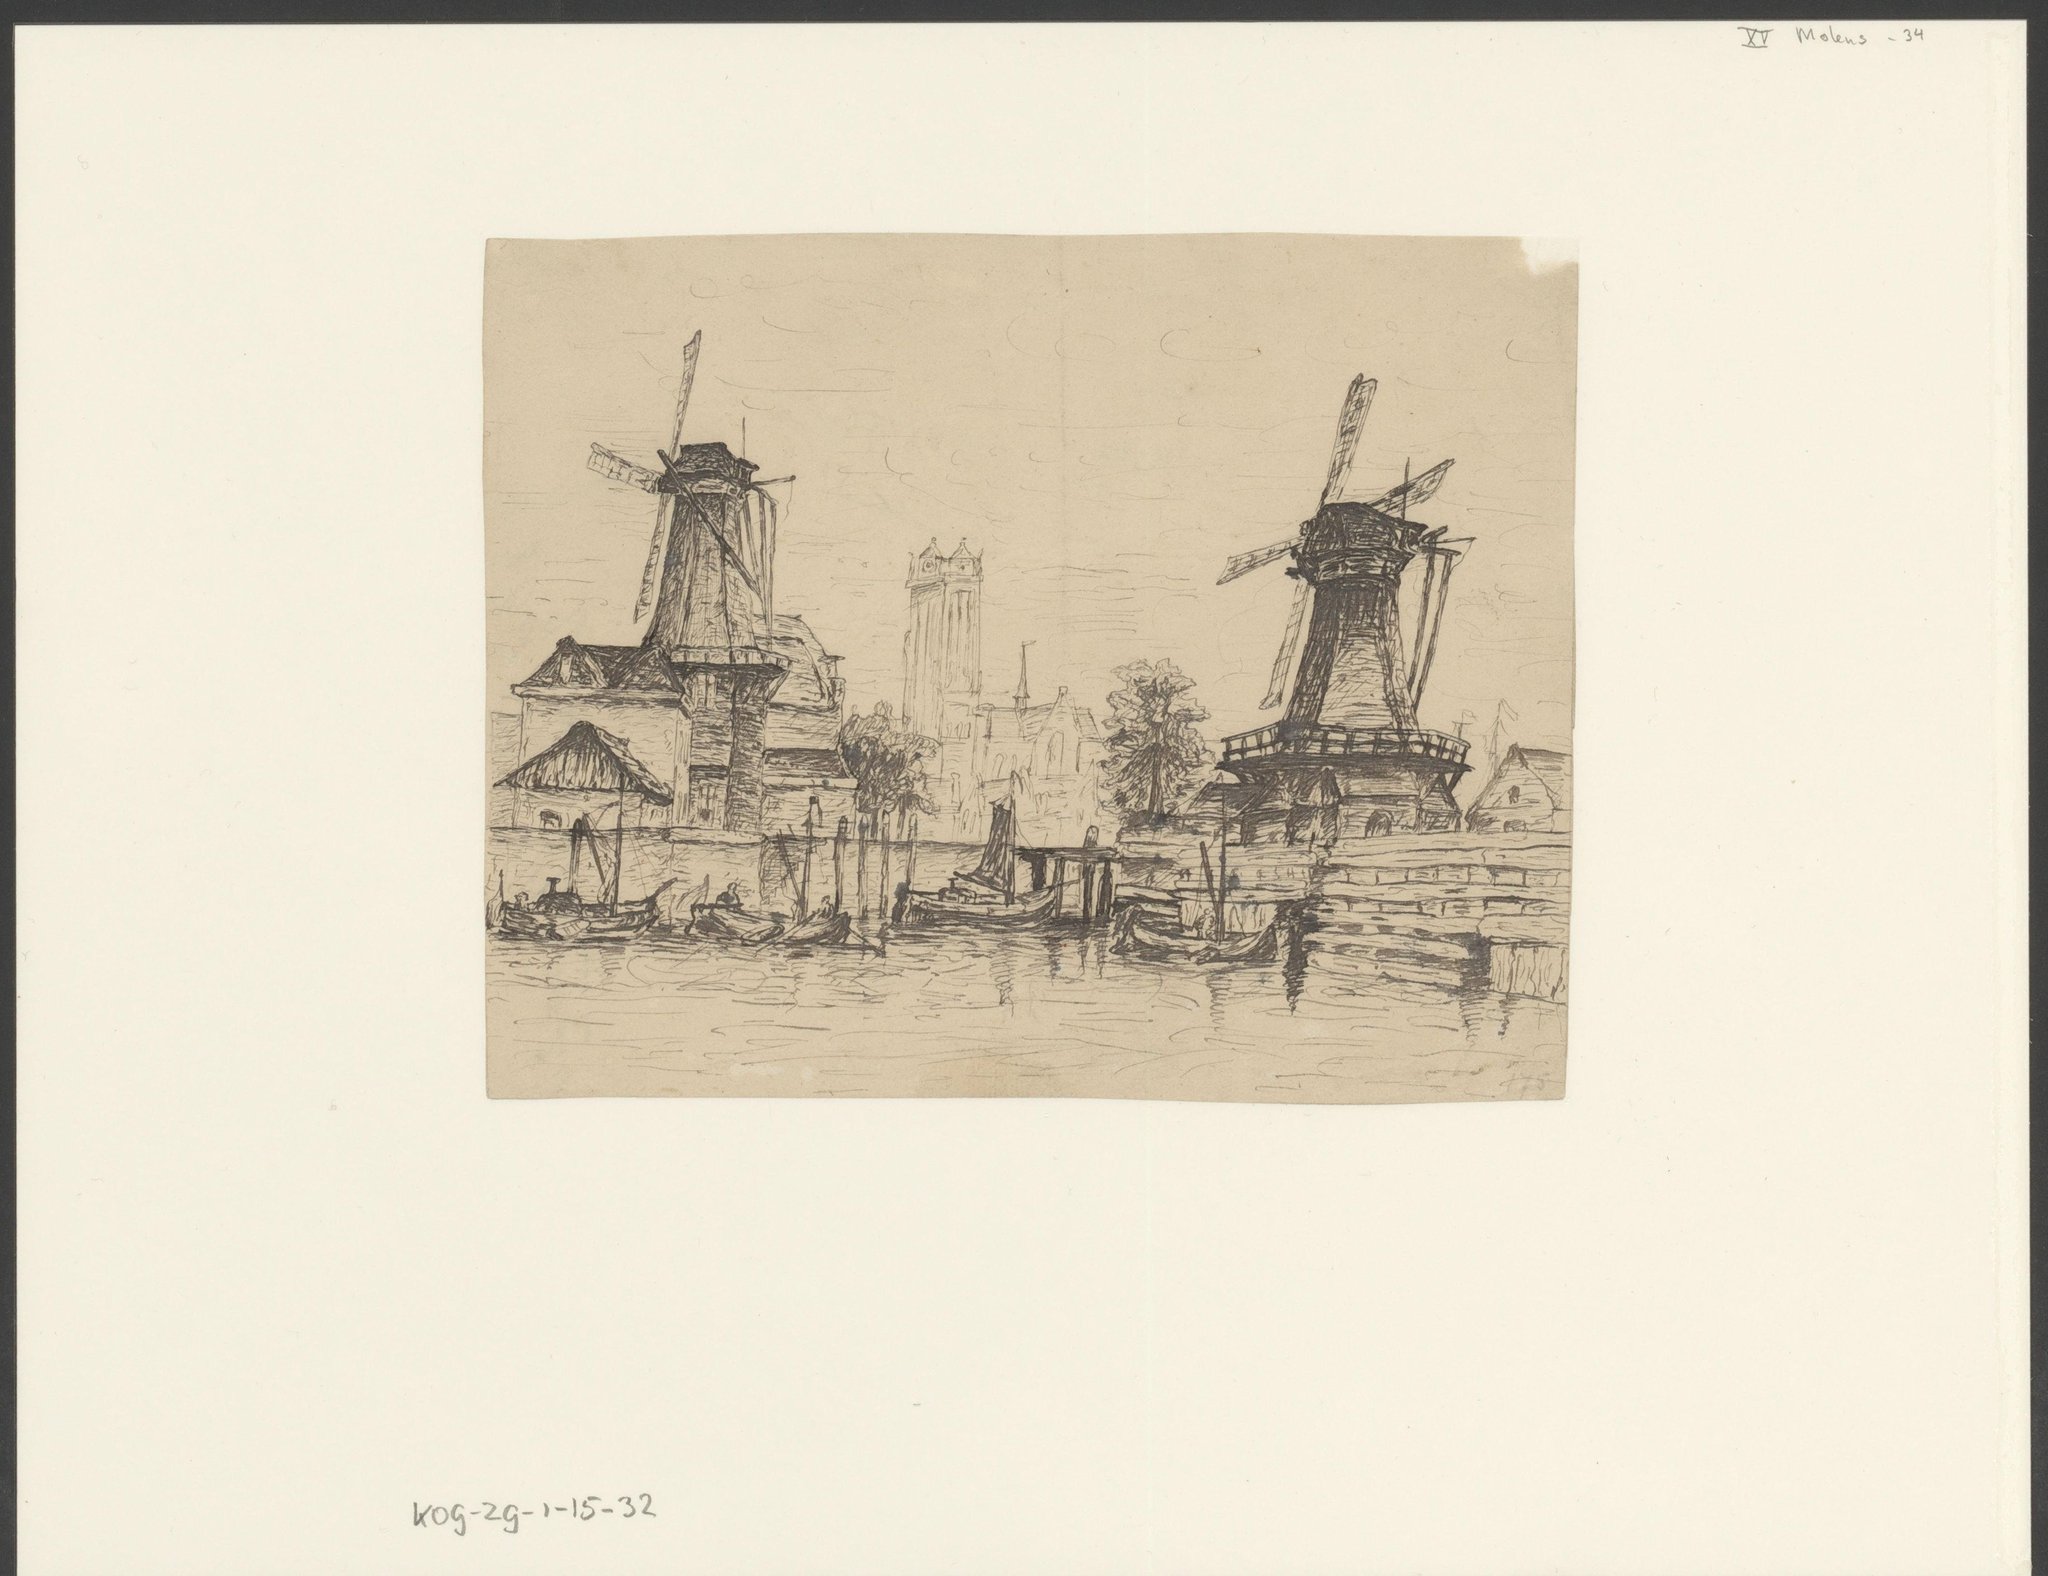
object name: drawing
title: Twee molens bij een werf nabij Dordrecht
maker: Anonymous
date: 1750-1849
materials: ink, paper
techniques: pen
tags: windmill in landscape, pier, quay, wharf, dordrecht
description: Onderwerpsrubrieken binnen de Atlas Zeden en Gewoonten: Handel, nijverheid en verkeer, Molens.